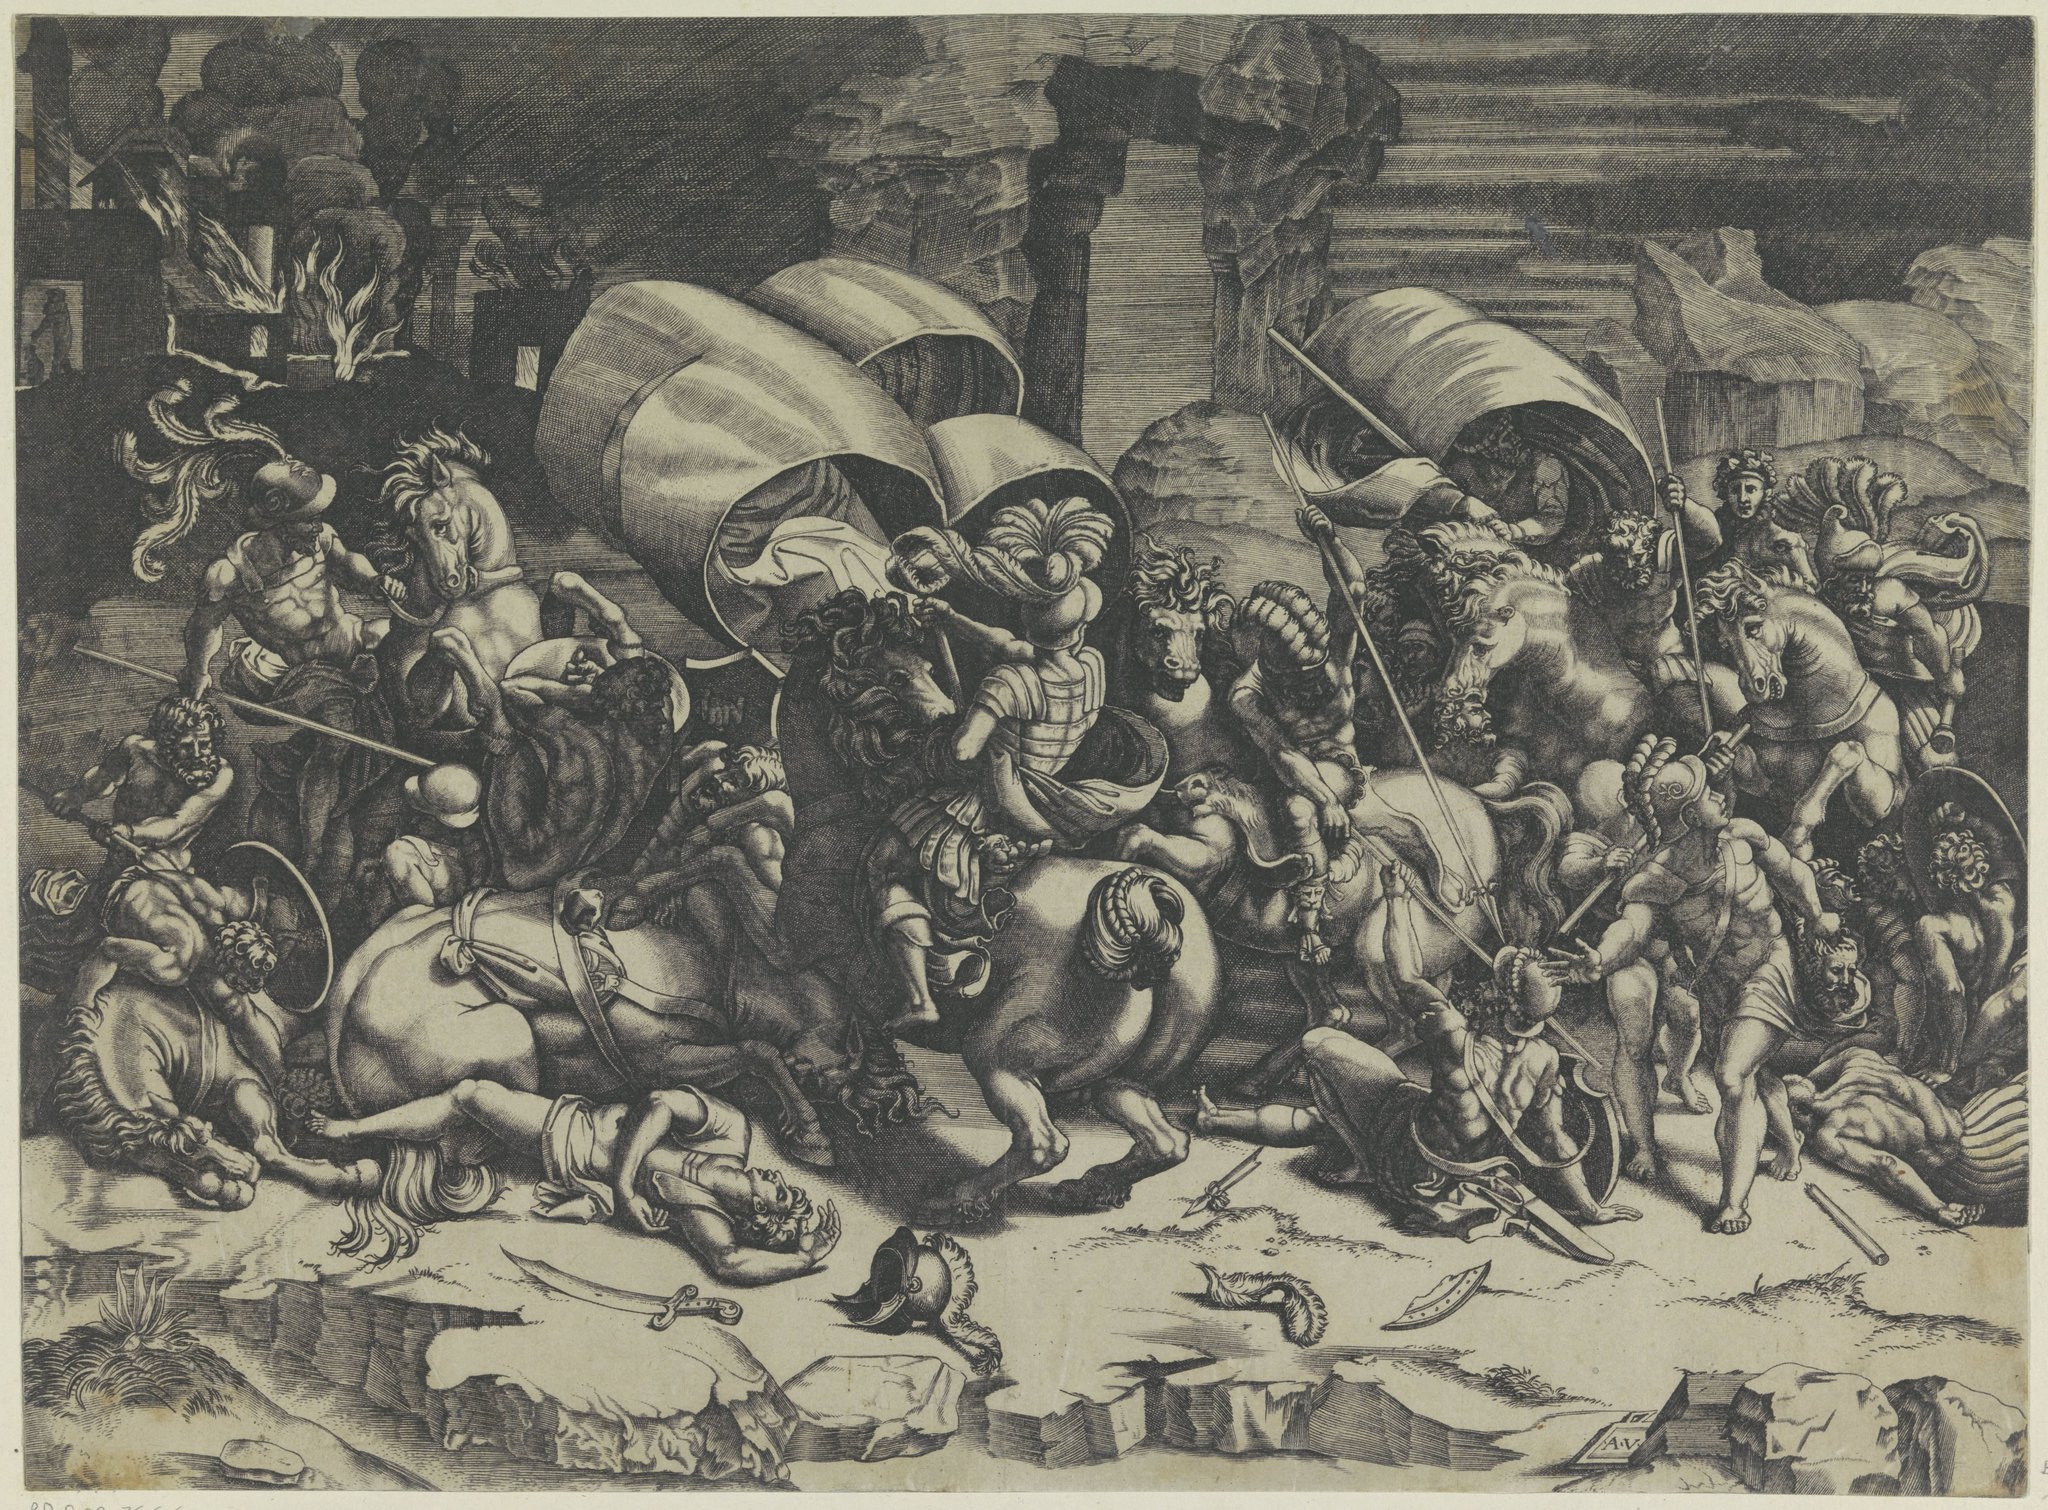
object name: print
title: Veldslag tussen Romeinen en Carthagers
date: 1500-1536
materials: paper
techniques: engraving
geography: italy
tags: battle, hacking and thrusting weapons: sword, (story of) p. cornelius scipio africanus minor (p. cornelius scipio aemilianus), setting on fire (of conquered city), the soldier; the soldier's life, fighting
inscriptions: collector's mark: Lugt 240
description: Bartsch beschrijft deze prent als spiegelbeeldige kopie door Agostino Veneziano naar een prent mogelijk door Marco Dente (Bartsch 211). Volgens Oberhuber is het echter andersom en is de spiegelbeeldige versie een kopie naar deze prent van Agostino Veneziano. De compositie gaat mogelijk terug op een tekening van Giulio Romano.